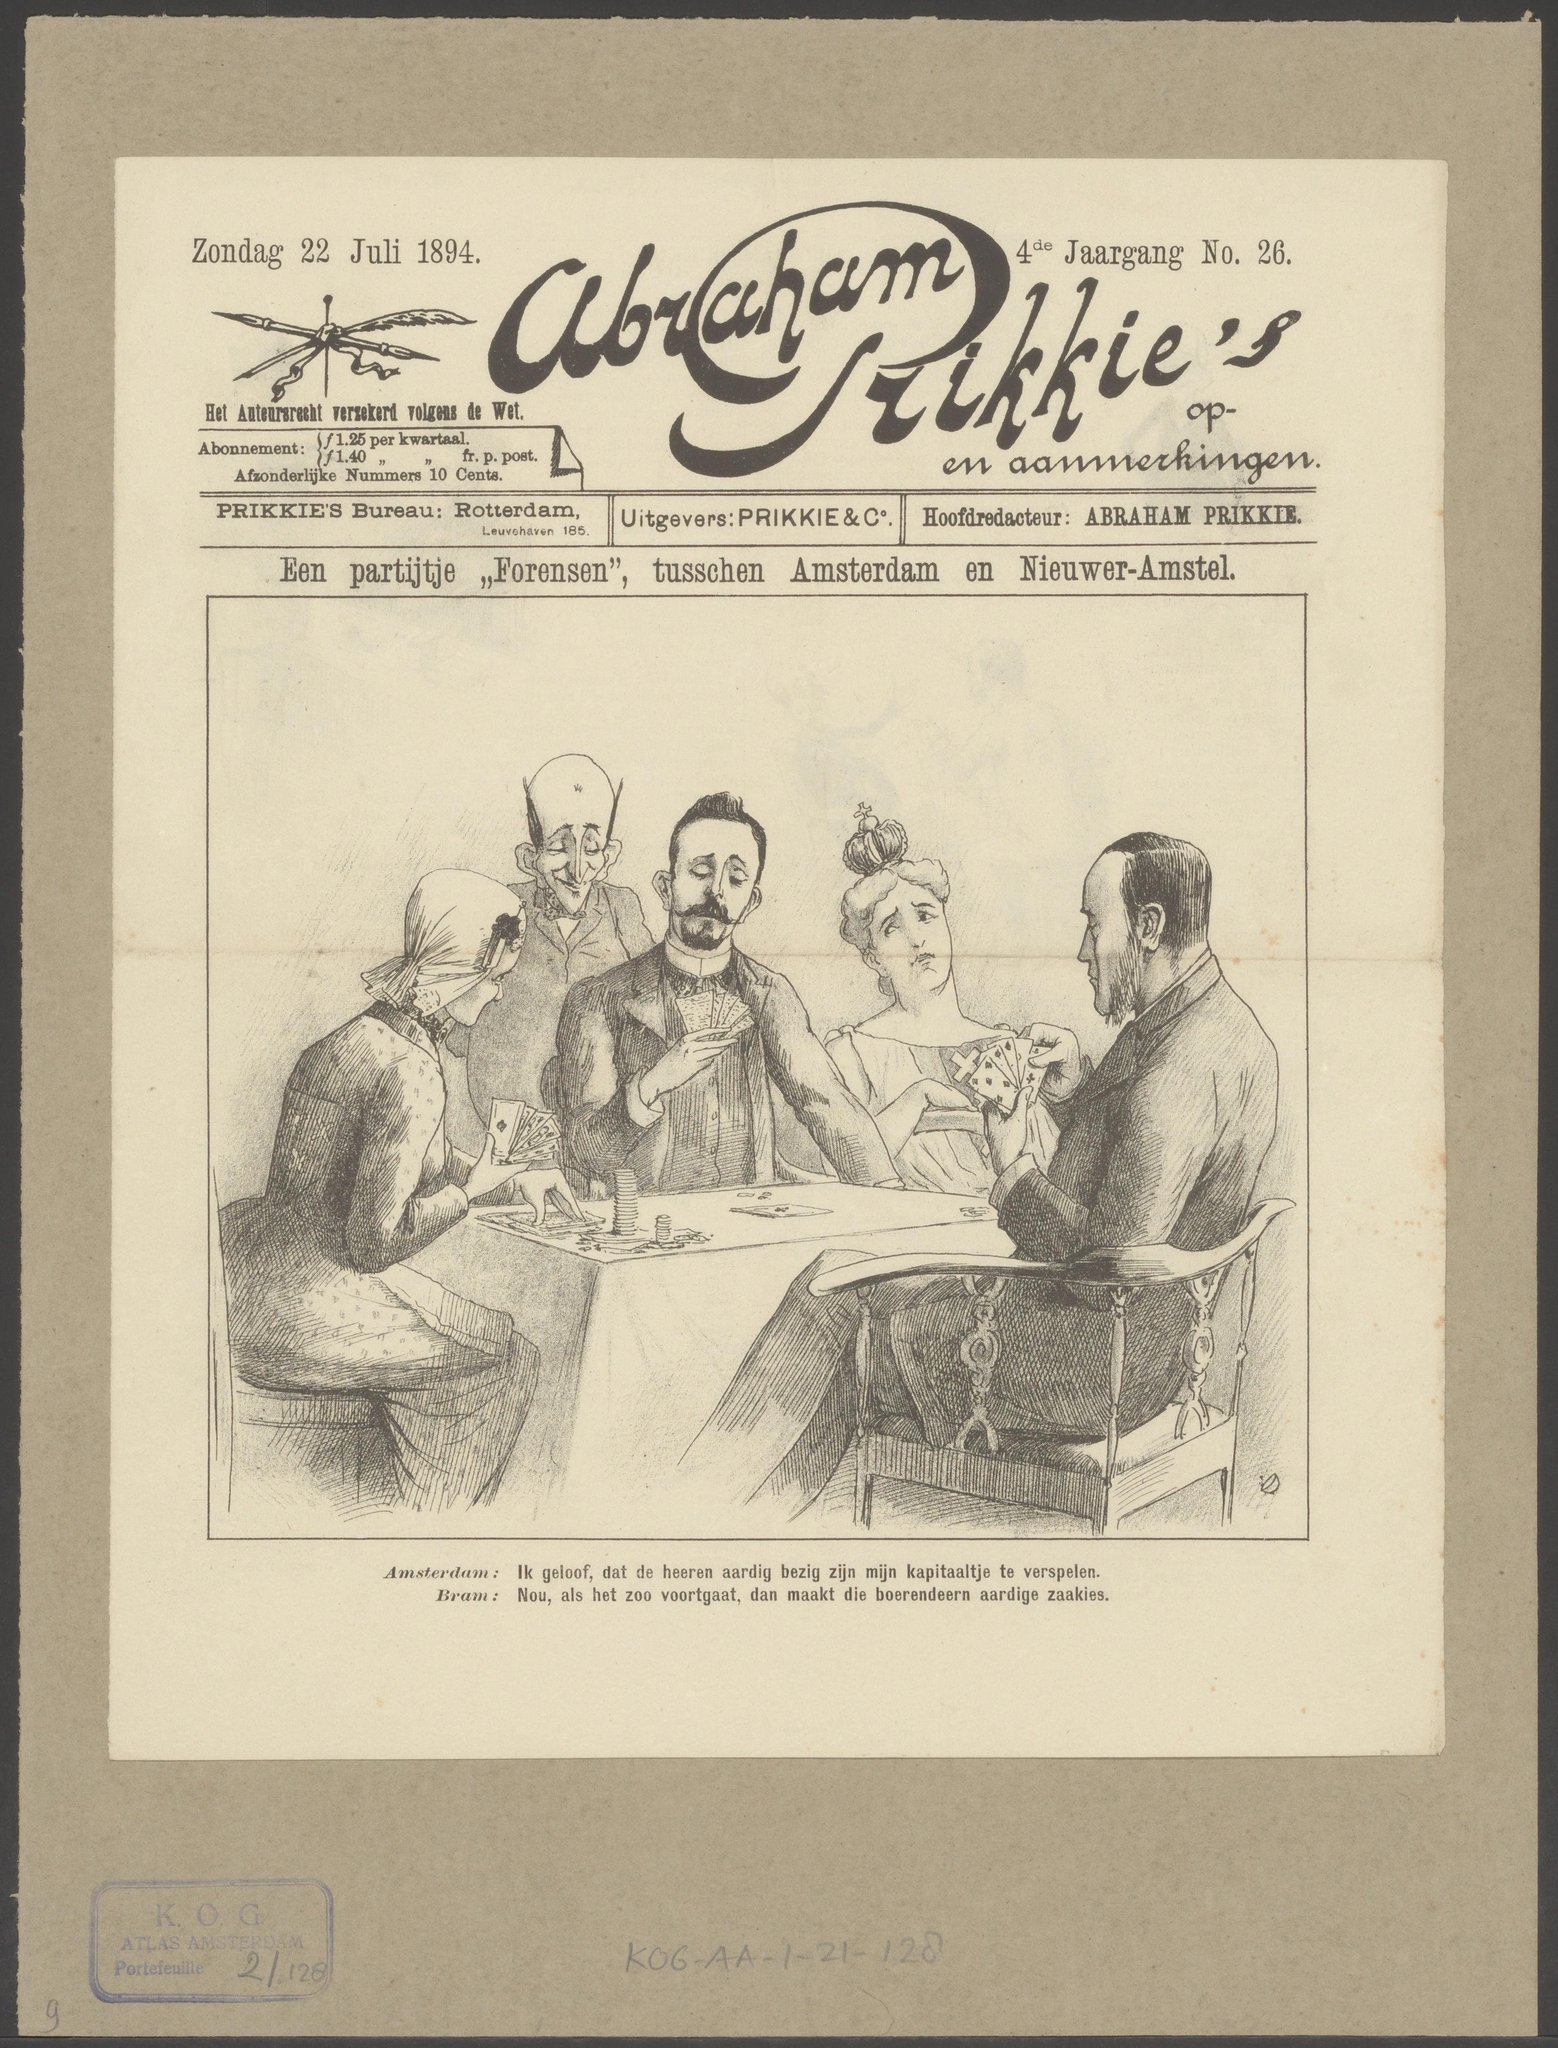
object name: cartoon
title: Willem Treub, Sjoerd Anne Vening Meinesz en een vrouw spelen een kaartspel; de stedenmaagd van Amsterdam kijkt bezorgd toe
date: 1894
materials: paper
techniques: letterpress printing, lithograph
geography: rotterdam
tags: harlingen, politician, the hague, personification of a city, town-patron(ess), mayor, burgomaster, tax payment, games of calculation and chance, e.g.: card games, gambling, puzzles, etc., card games, playing-cards, municipal government, taxes and financial administration, political caricatures and satires, amsterdam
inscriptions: collector's mark: Lugt 1641b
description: Met wethouder Willem Treub, burgemeester Sjoerd Anne Vening Meinesz en een boerin die Nieuwer-Amstel (Amstelveen) personifieert. Onderwerpsrubriek binnen de Atlas Amsterdam: Belastingen.